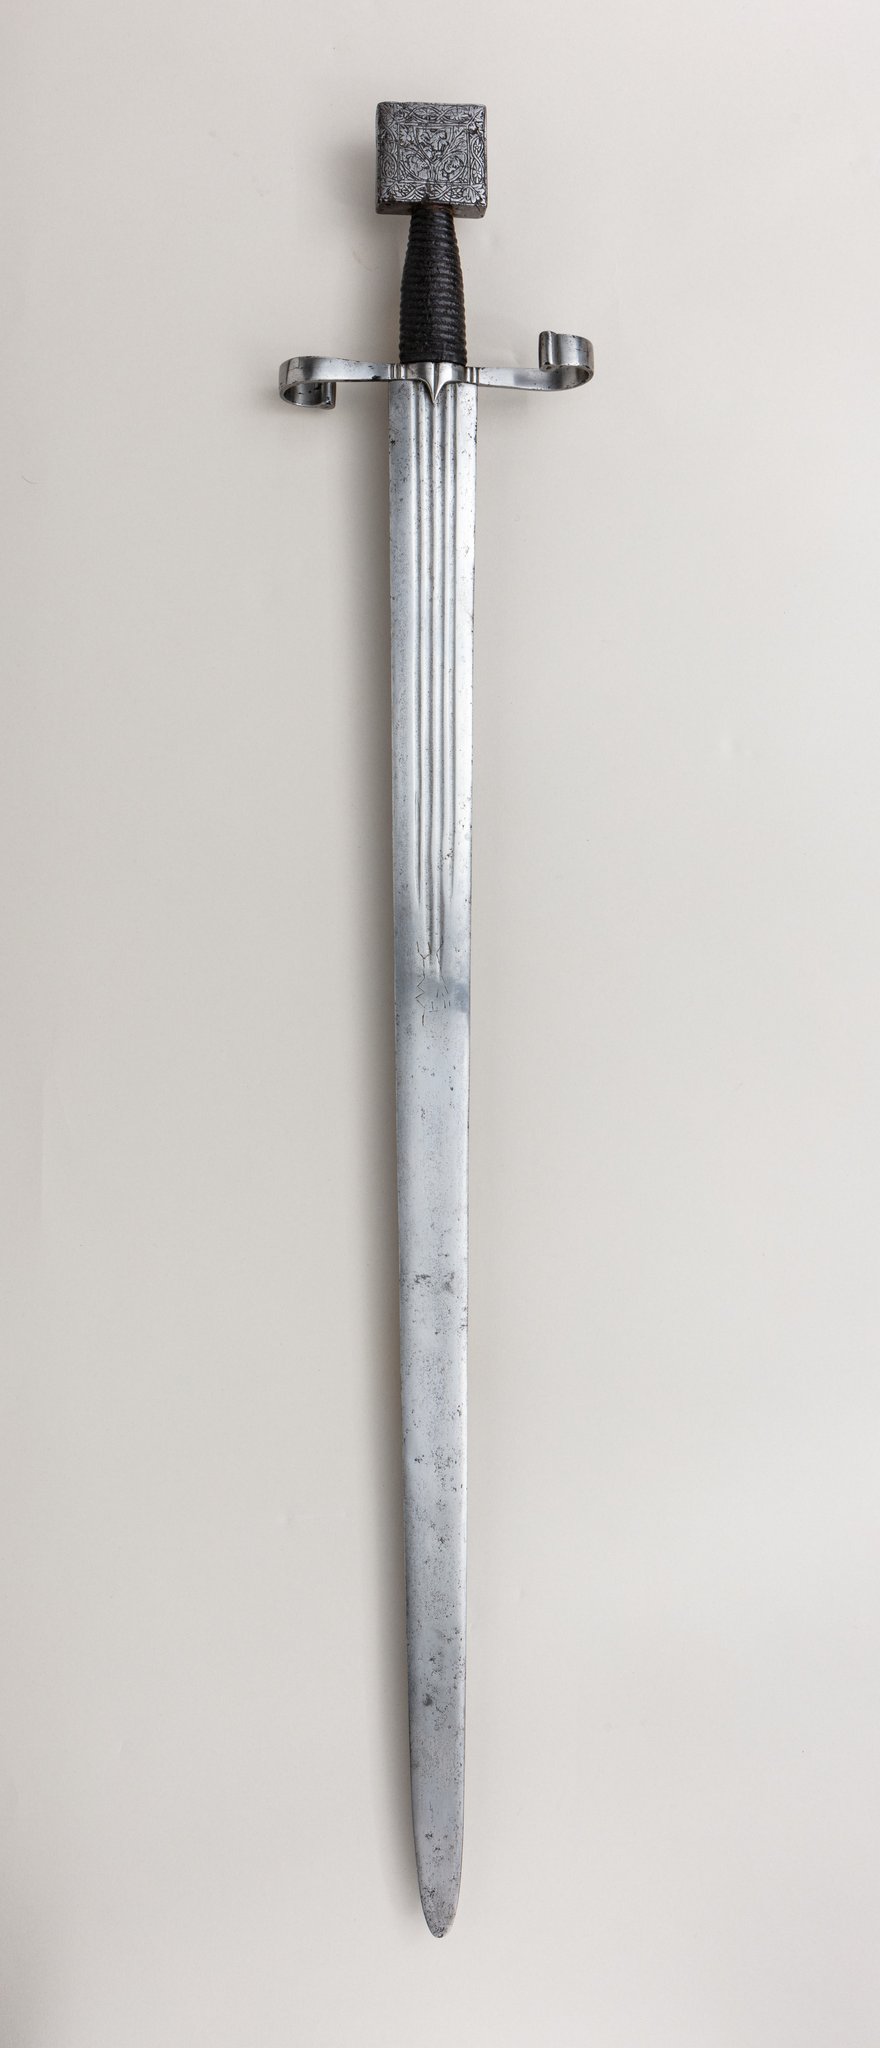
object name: early sword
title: Sword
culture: spanish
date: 1500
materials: leather, steel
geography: spain